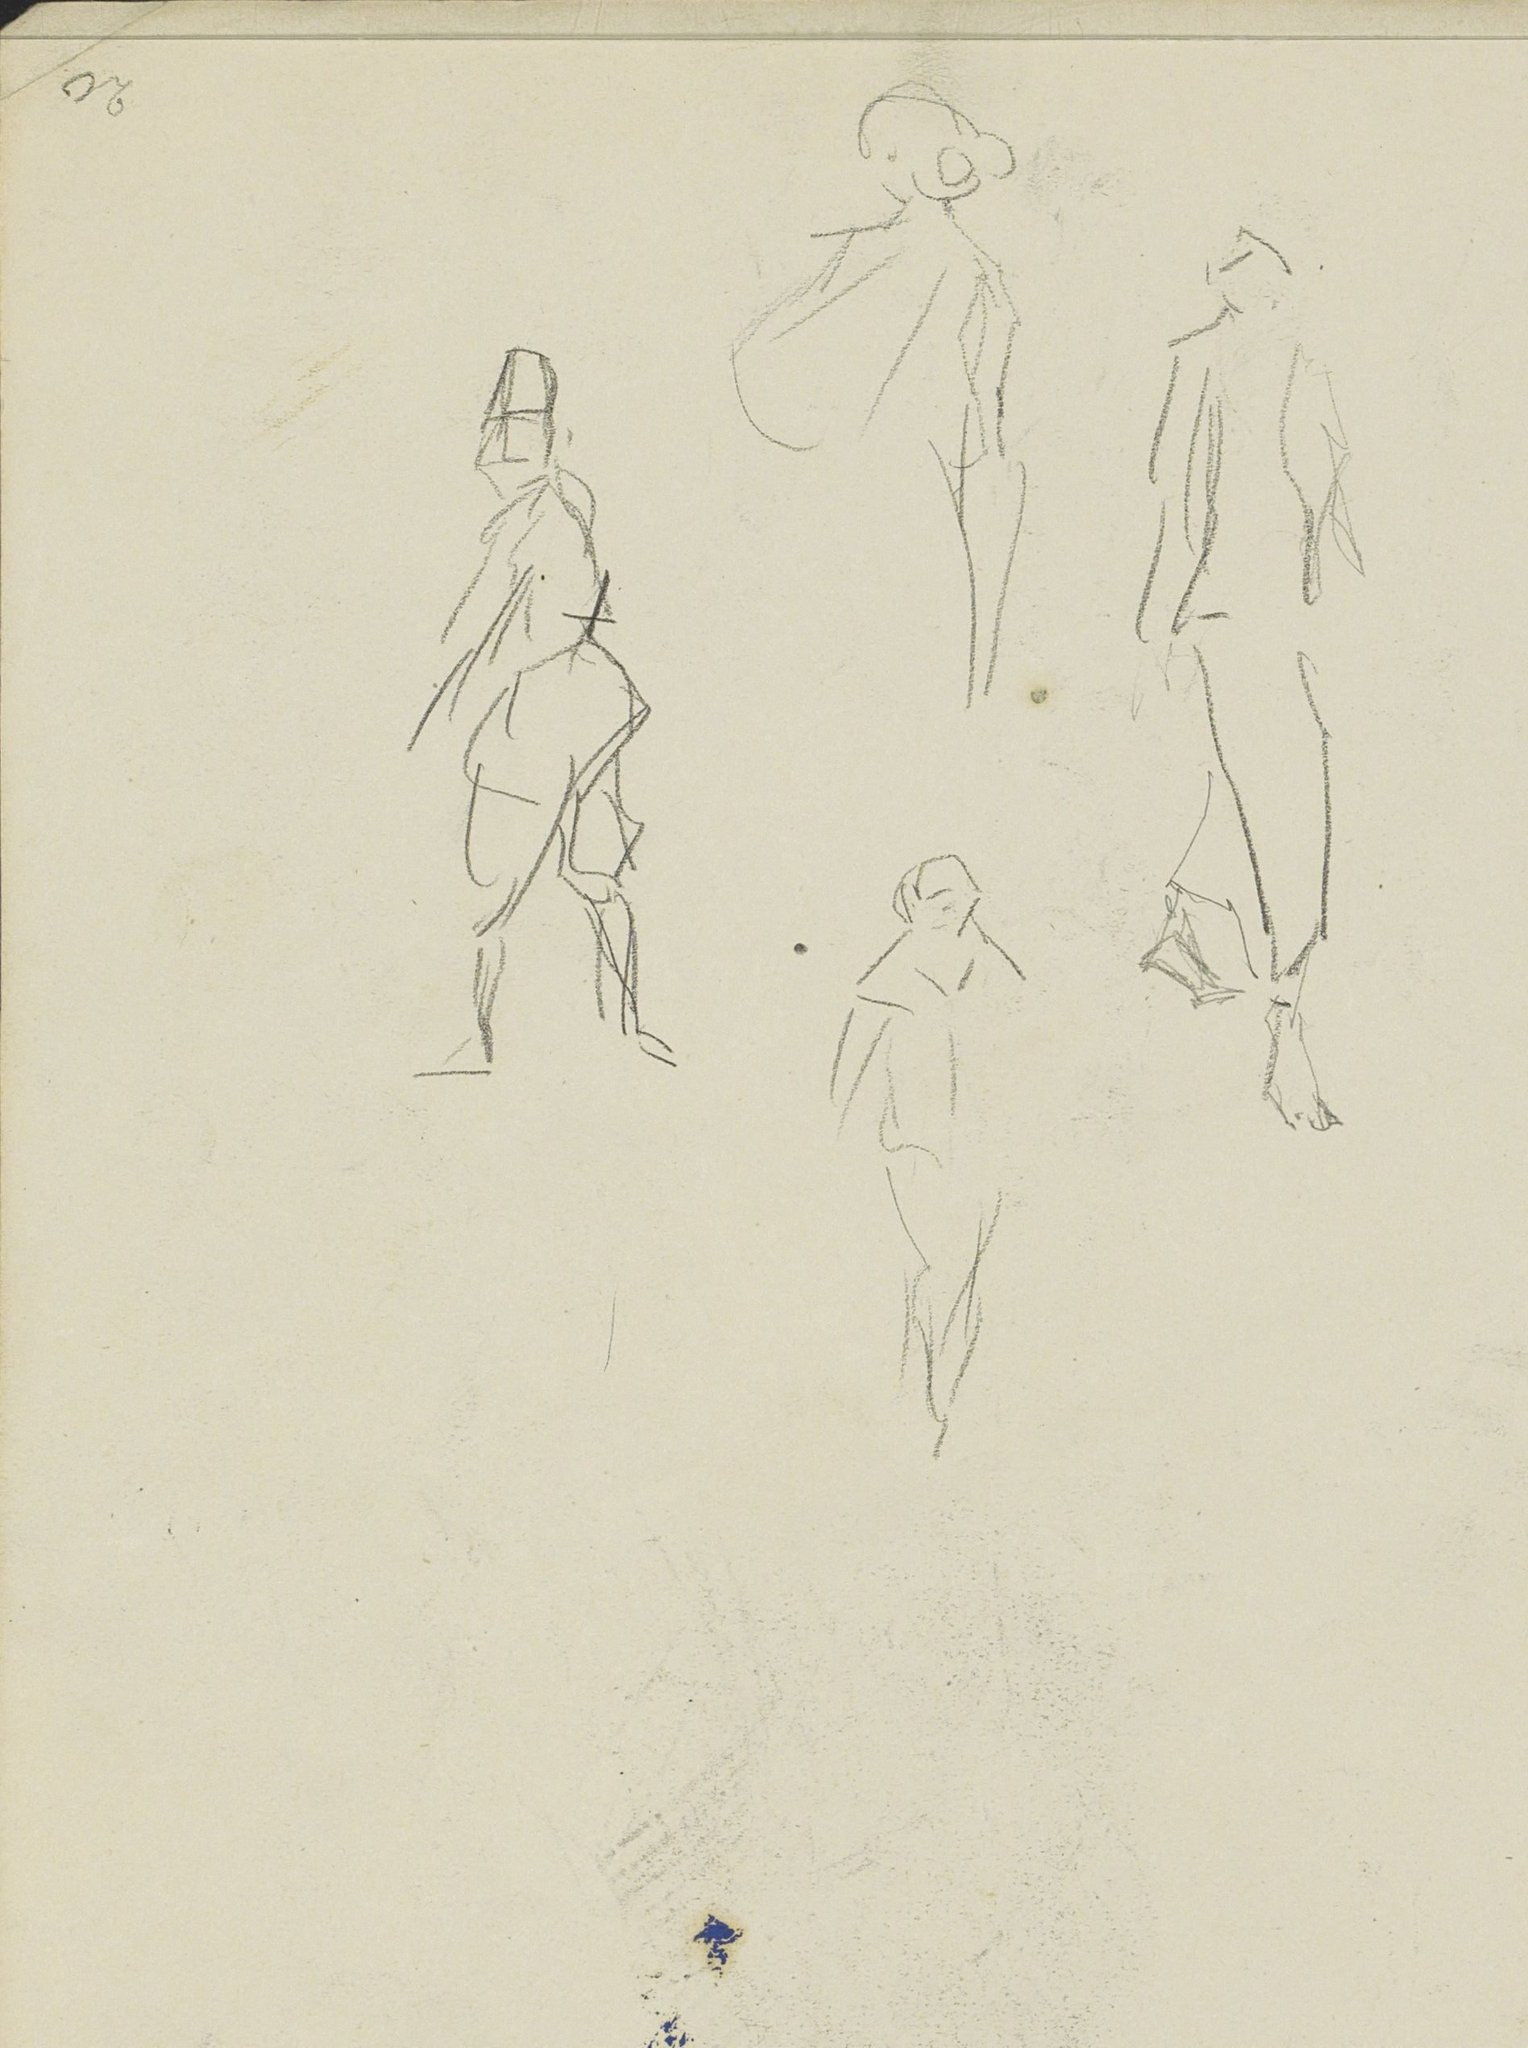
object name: sketchbook leaf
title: Staande figuren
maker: isaac israels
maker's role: draughtsman, painter, print maker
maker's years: 1865-1934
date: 1875-1934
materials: paper, pencil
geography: the hague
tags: standing figure, standing figure - aa - female human figure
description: Blad 1 verso uit schetsboek XXIV met 10 bladen.